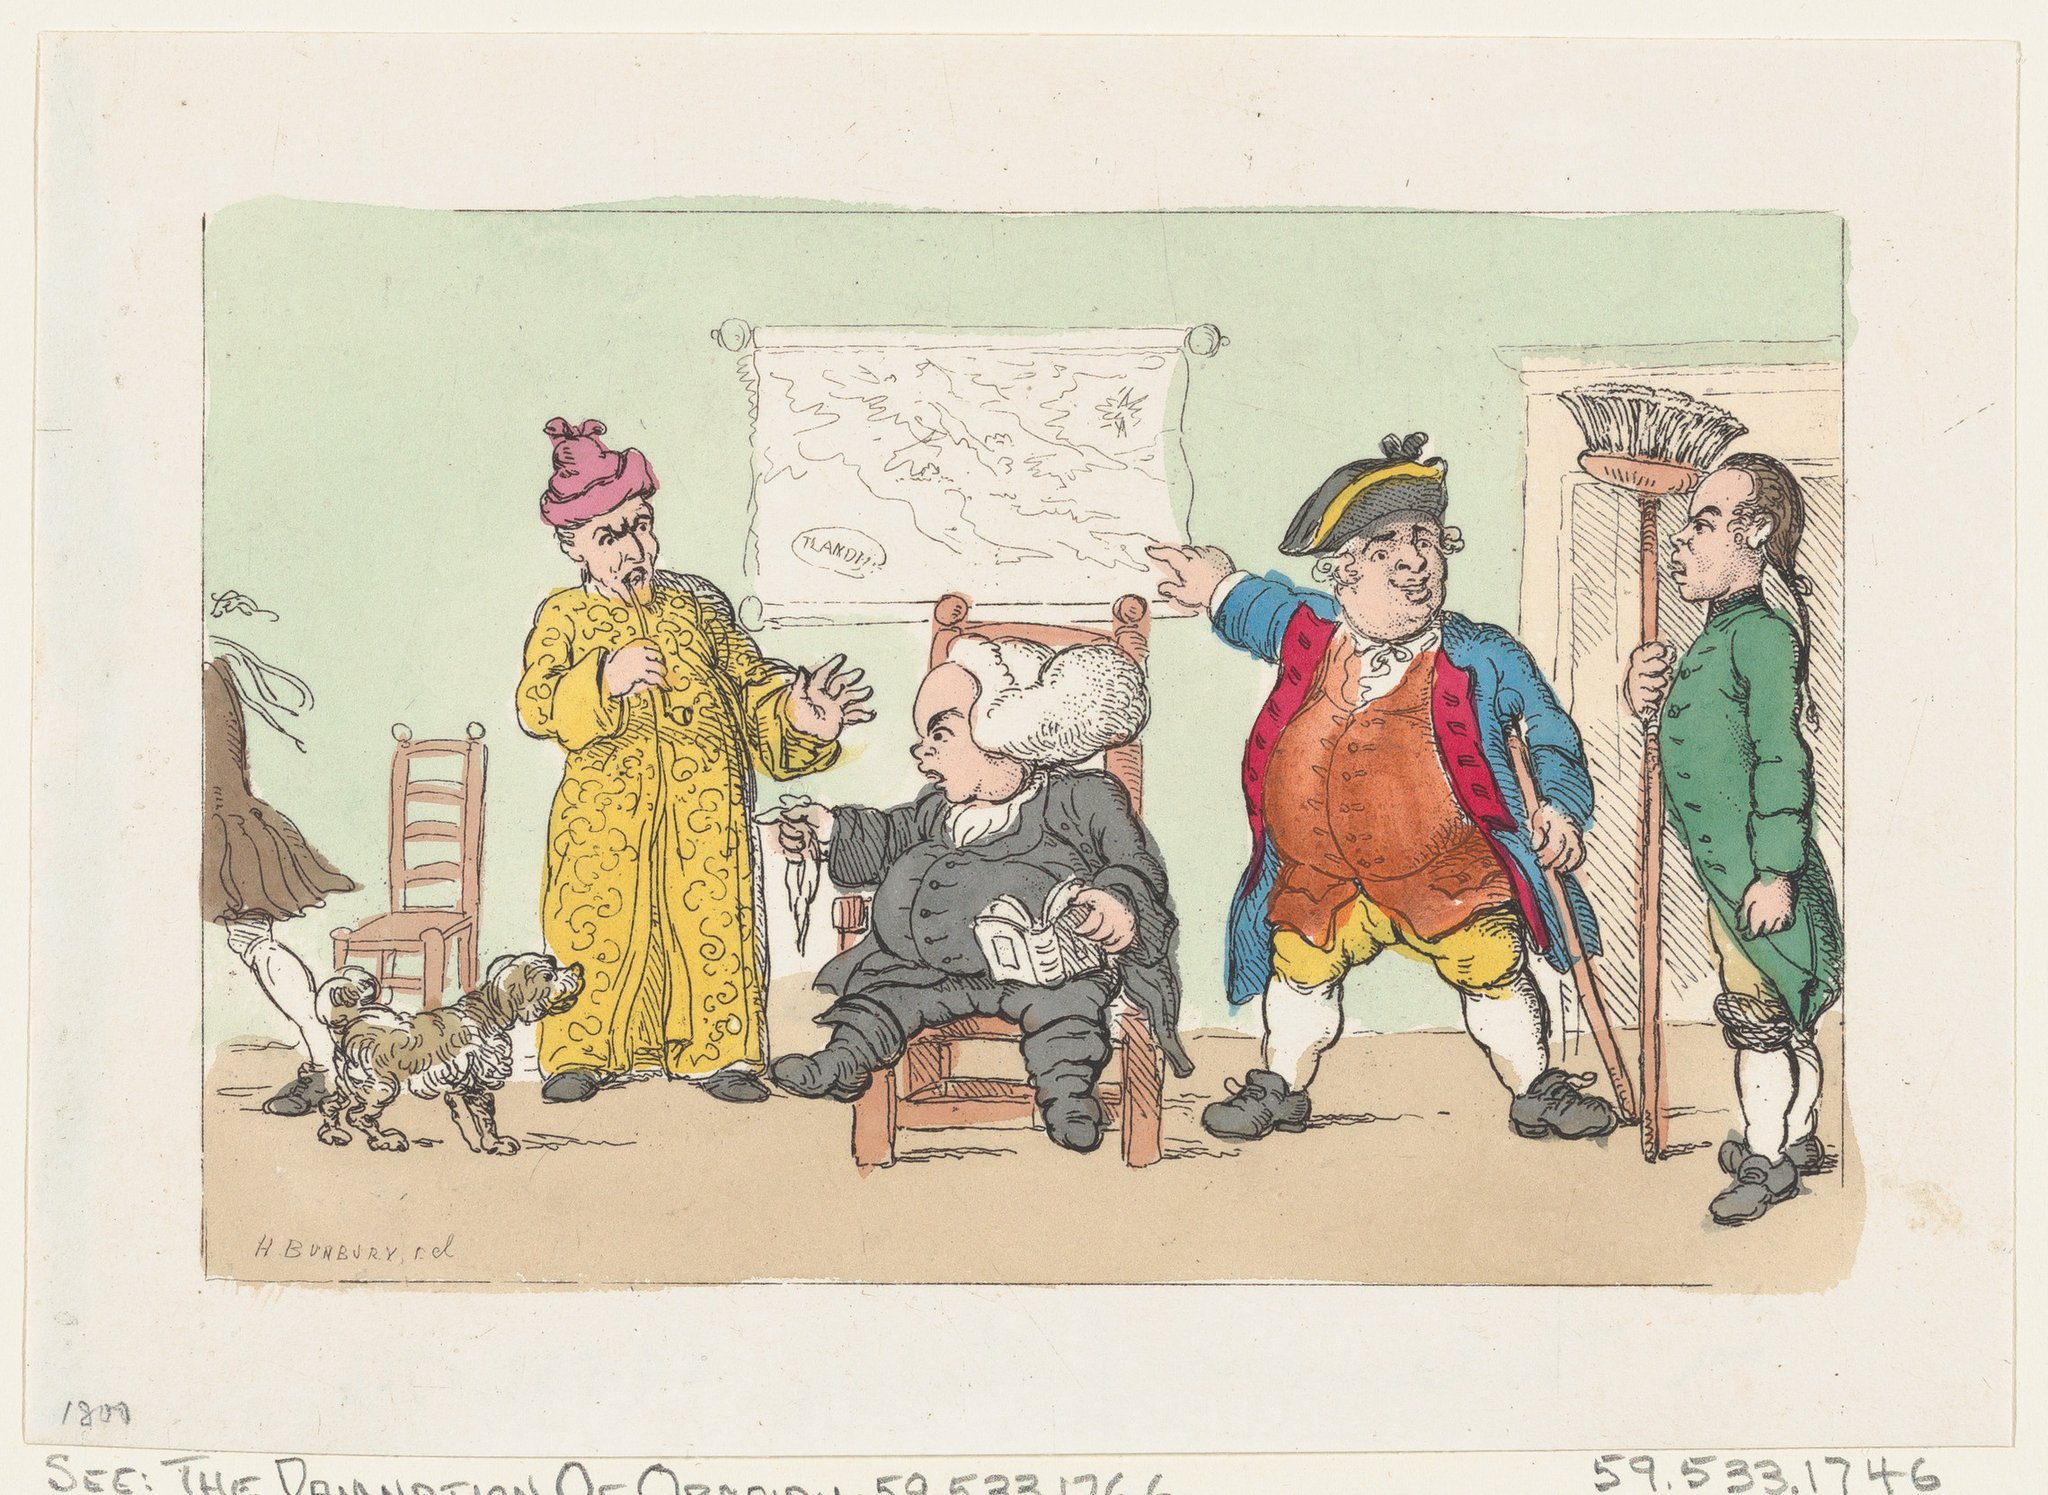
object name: print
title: The Damnation of Obadiah (Tristram Shandy)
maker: thomas rowlandson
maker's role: artist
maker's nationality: british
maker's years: 1757-1827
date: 1803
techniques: etching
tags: satire,men,dogs